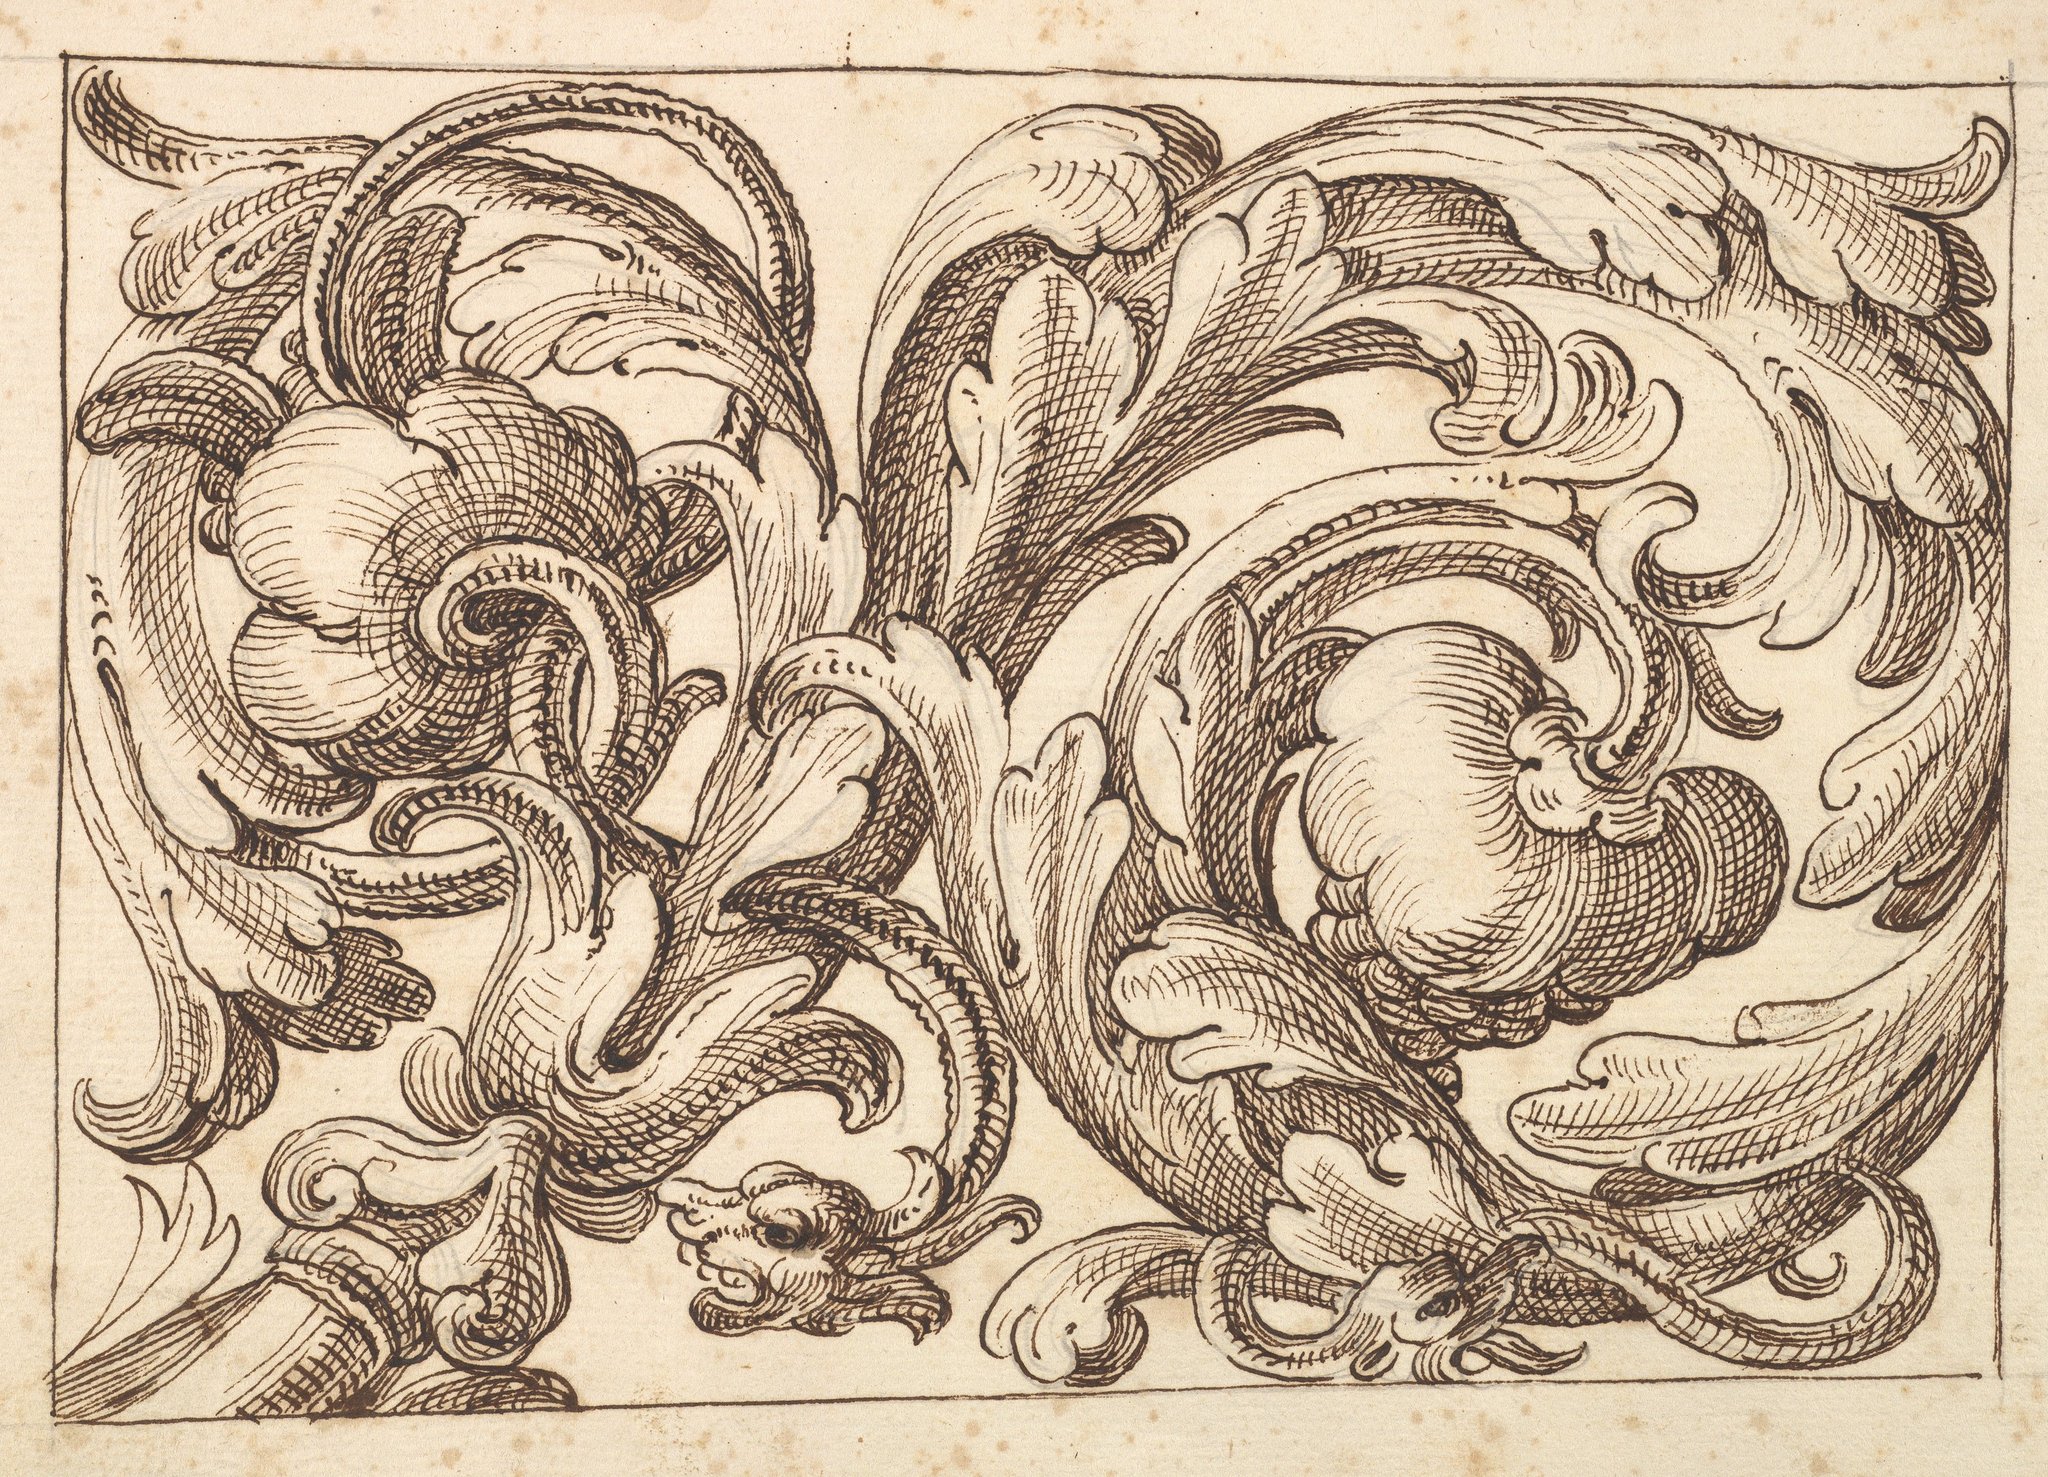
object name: collection ornament architecture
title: Horizontal Panel Design Filled with a Meandering Acanthus Rinceau and Two Fantastical Creatures.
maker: anonymous, italian, venetian, 17th century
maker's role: artist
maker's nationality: italian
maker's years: 1600-1700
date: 1601-1700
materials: ink, drawing material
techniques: pen